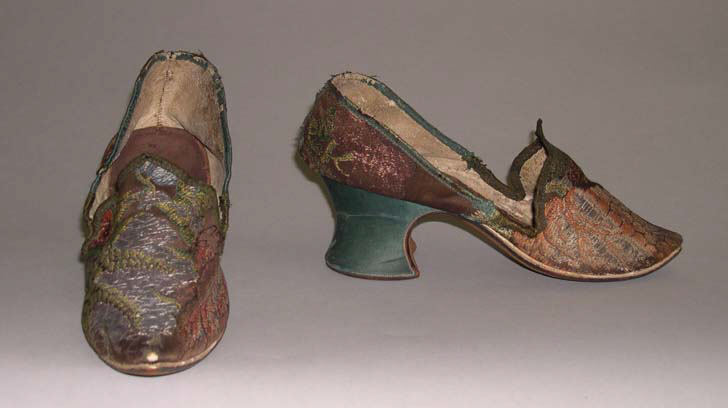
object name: shoe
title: Shoes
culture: british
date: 1740-1779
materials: silk